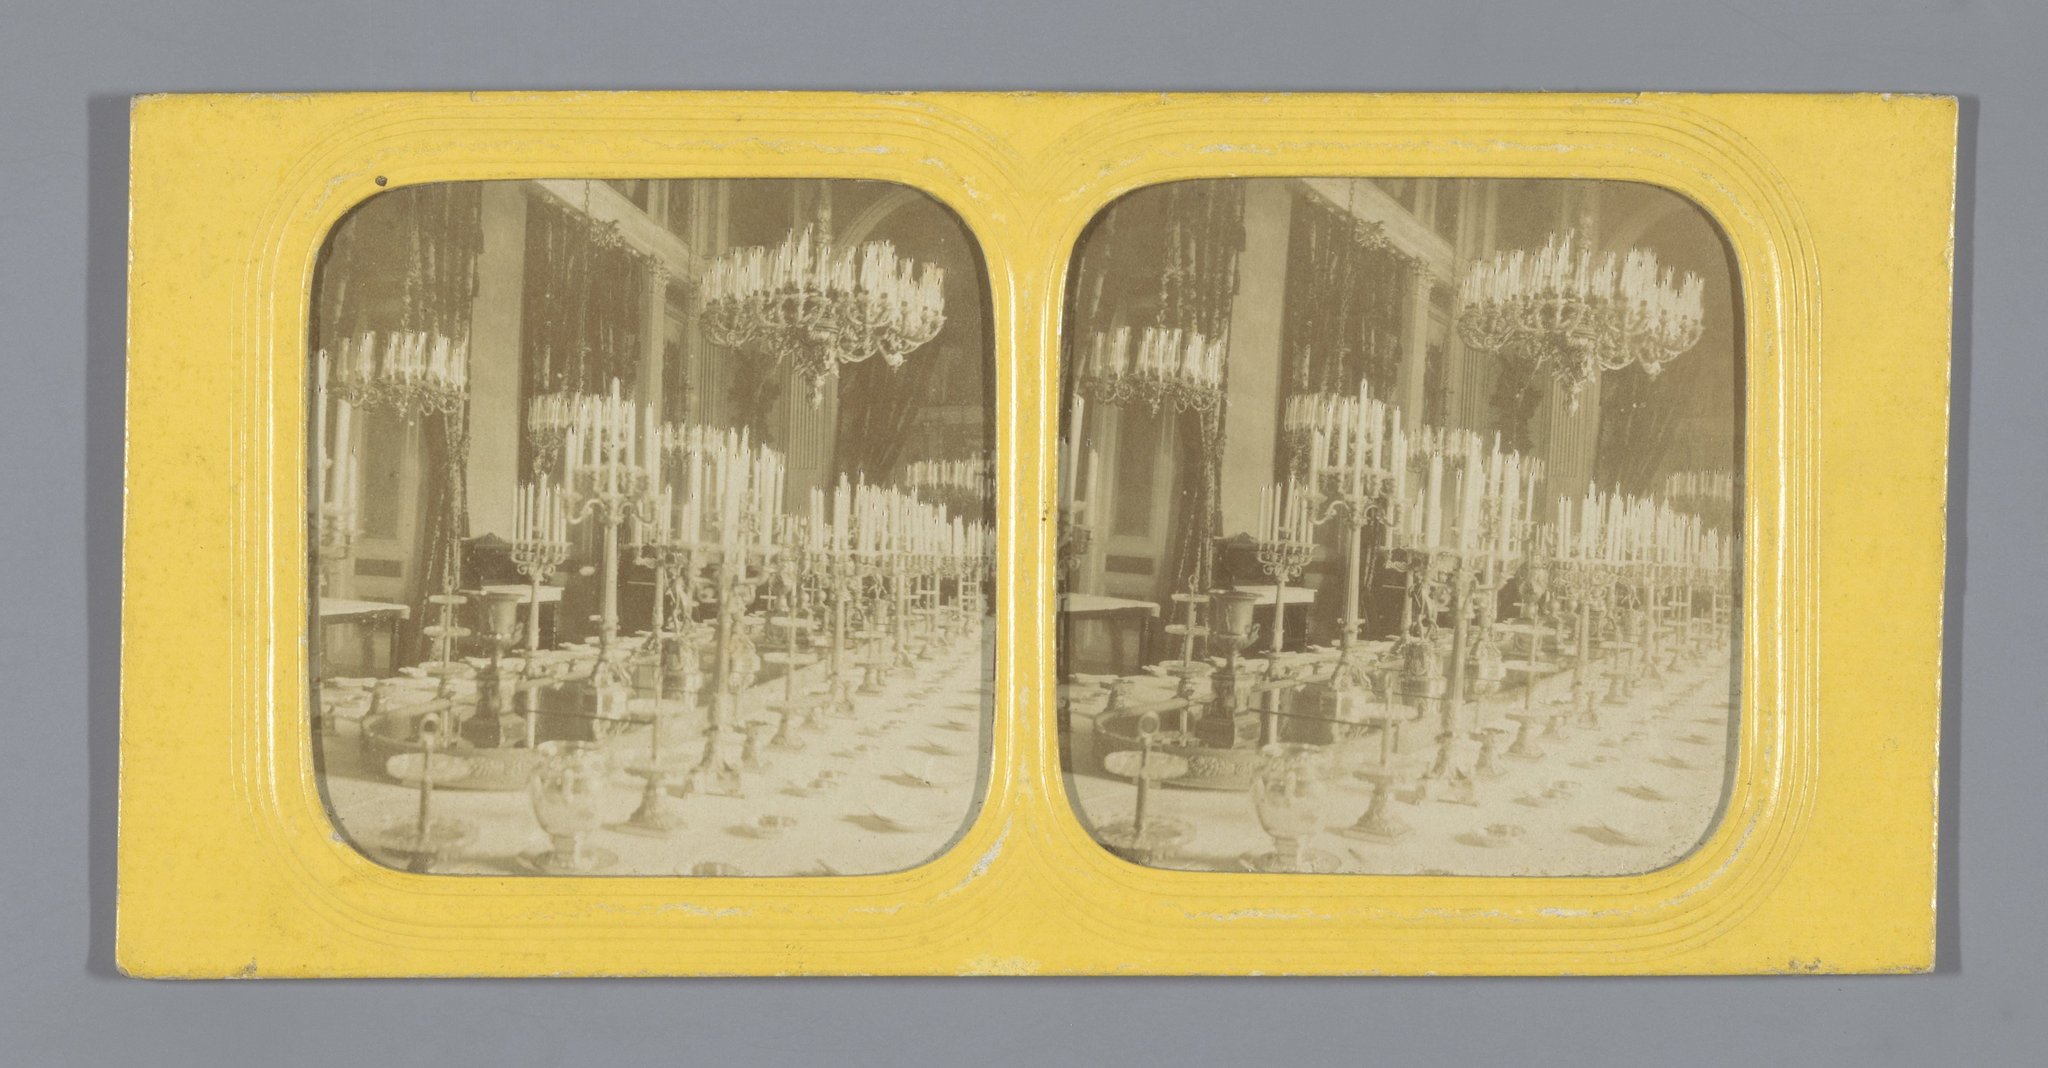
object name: tissue stereograph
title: Salon du diner du préfet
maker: Anonymous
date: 1855-1875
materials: cardboard, paper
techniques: albumen print, hand coloring, perforating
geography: paris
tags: dining-room